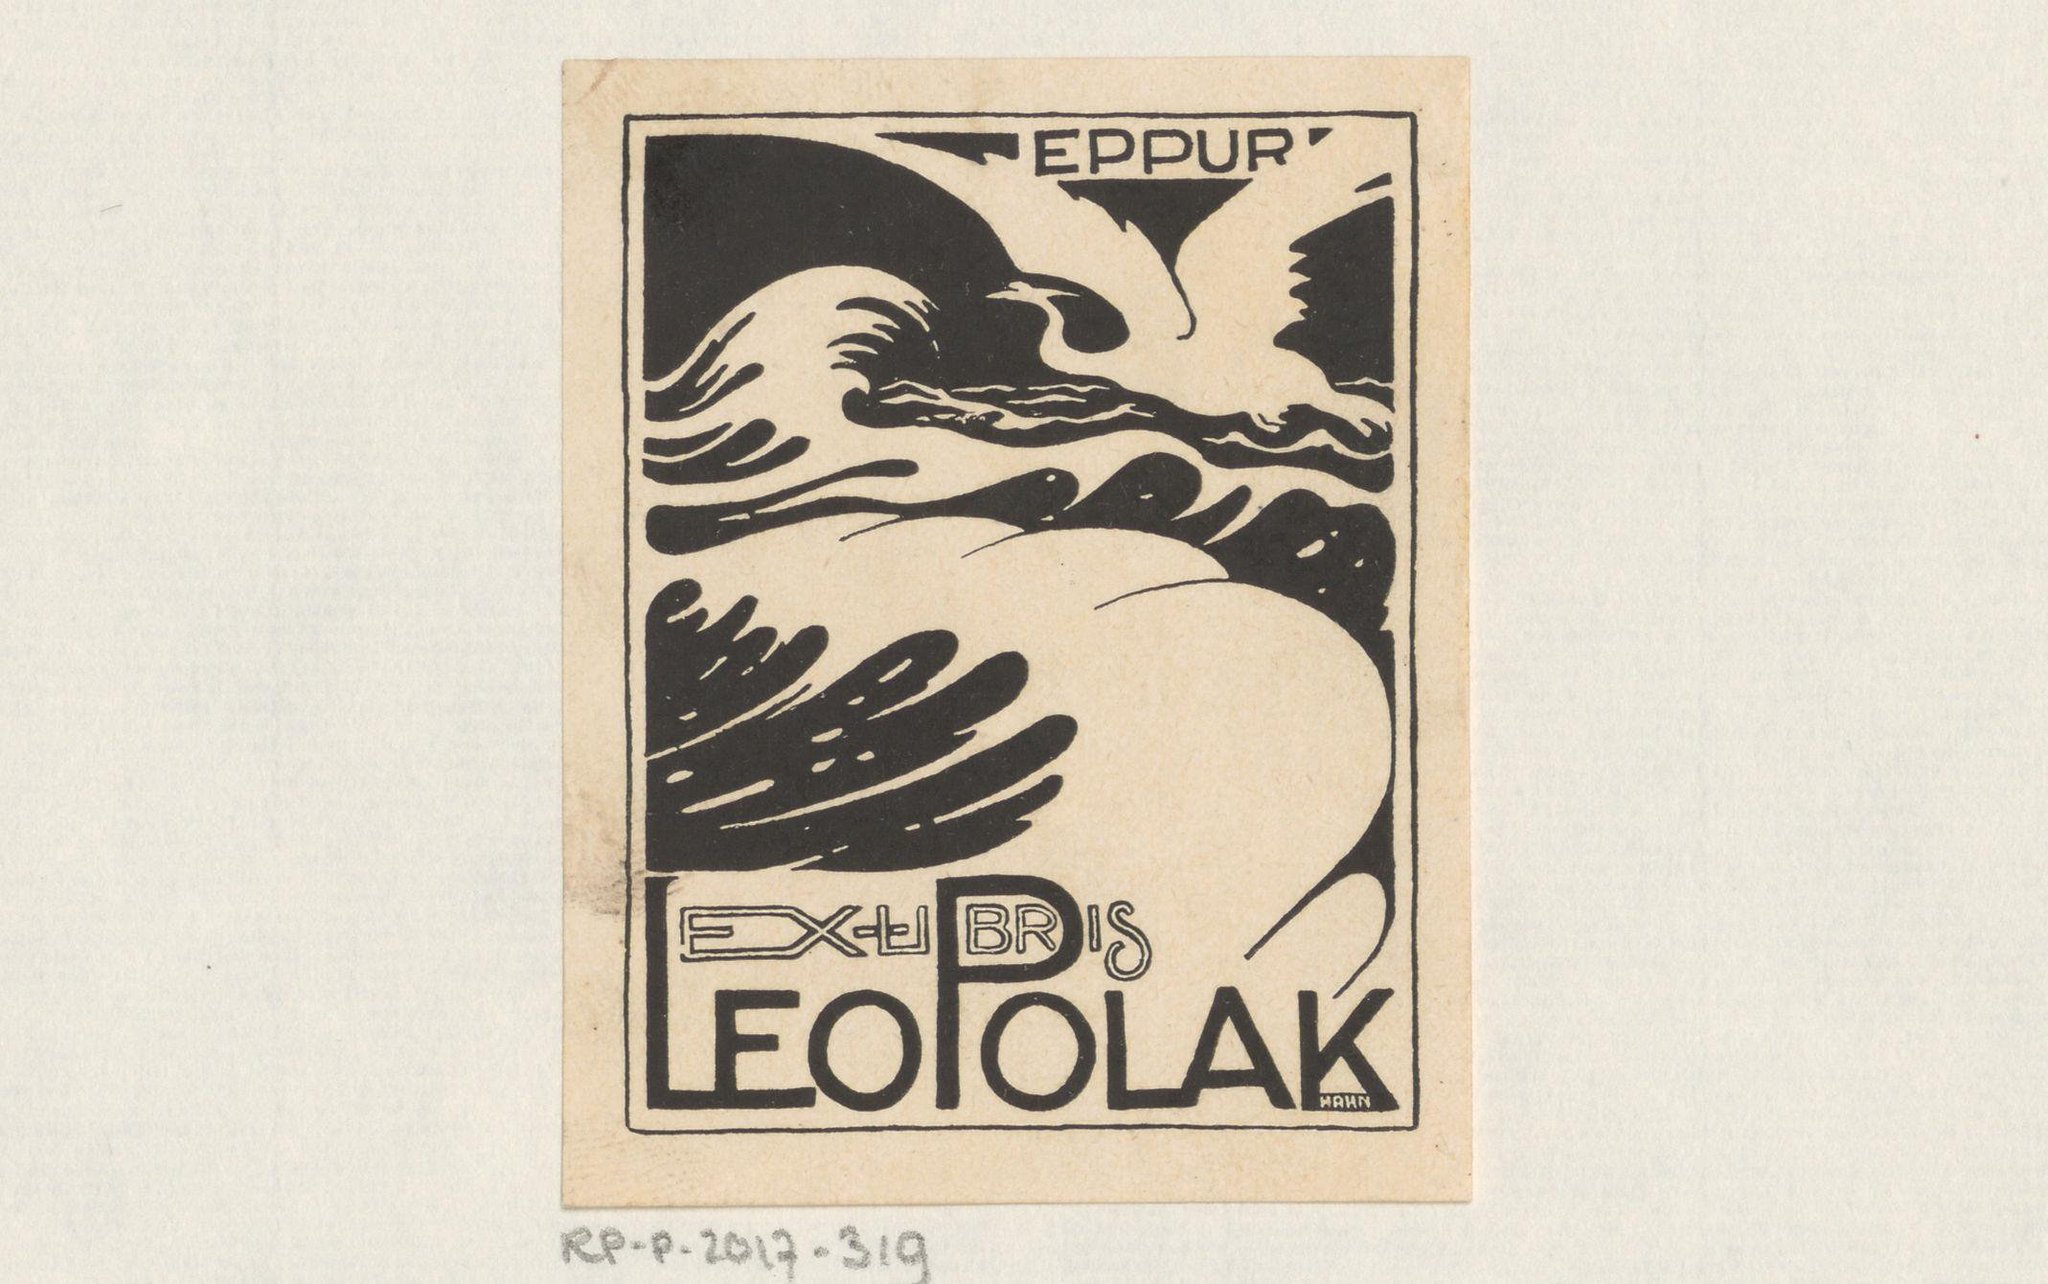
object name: bookplate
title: Ex libris van Leo Polak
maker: albert hahn (i)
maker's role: draughtsman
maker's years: 1877-1918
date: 1917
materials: paper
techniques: printing block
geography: netherlands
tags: birds, sea